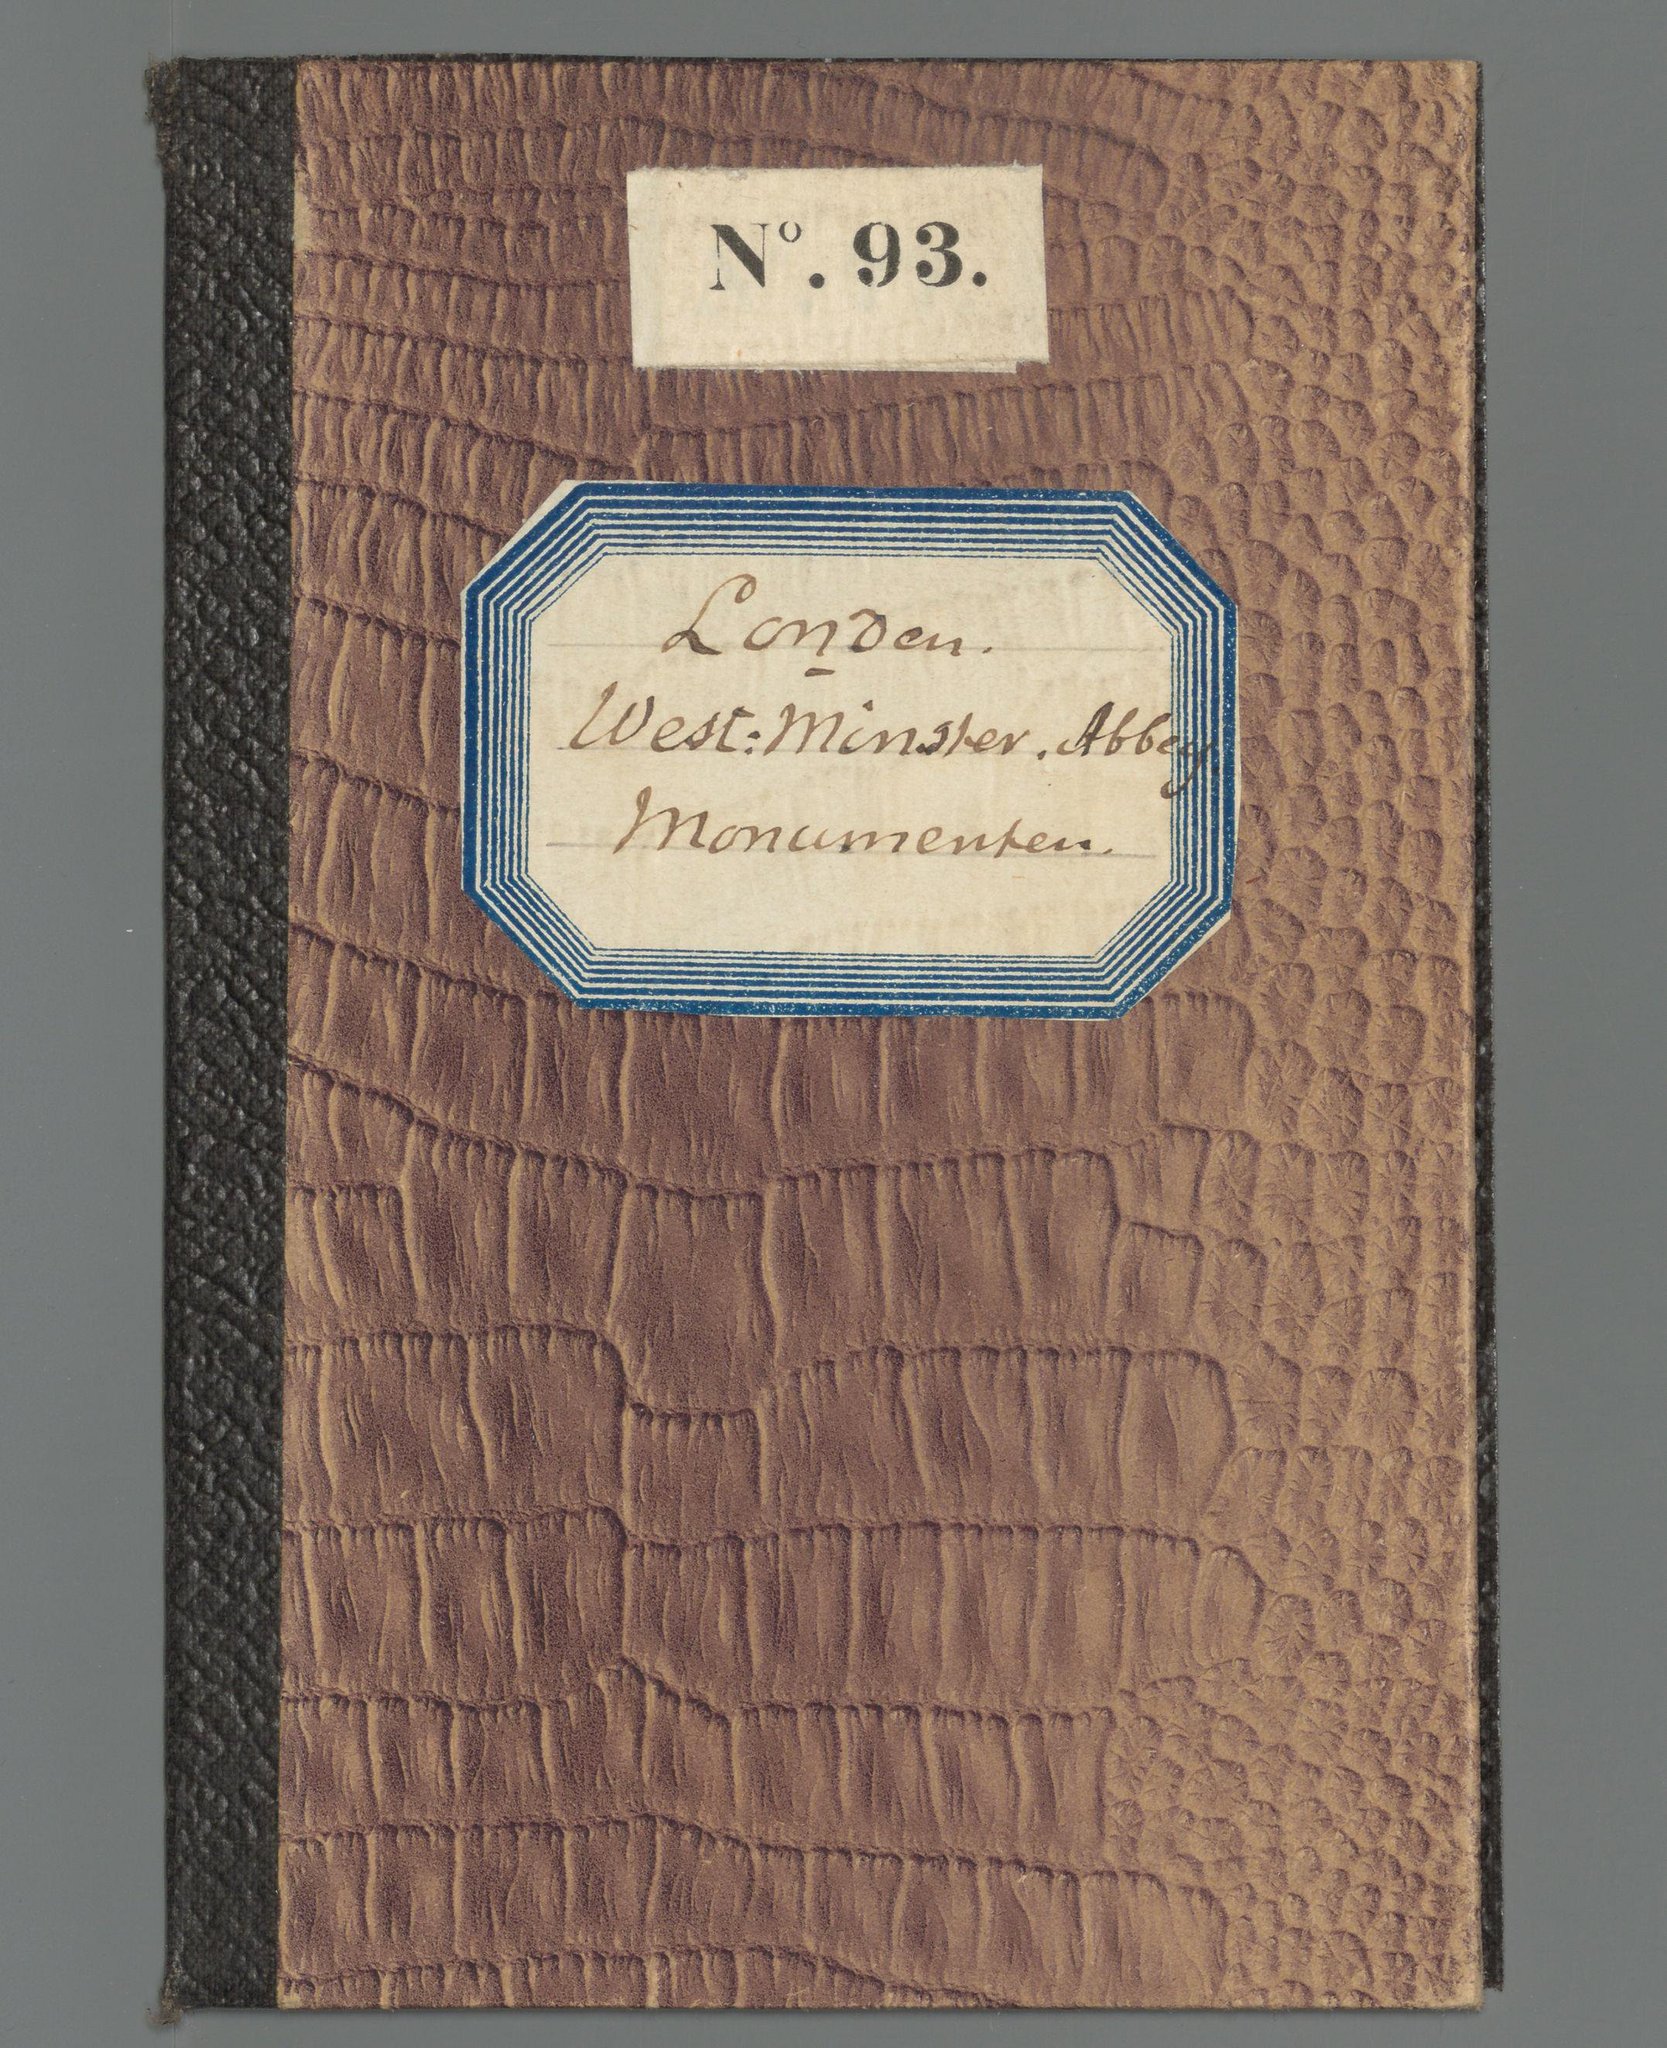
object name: wrapper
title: Omslag voor 37 prentbriefkaarten met stadsgezichten uit London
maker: Anonymous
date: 1900-1950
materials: cardboard, paper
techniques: lithograph, writing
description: In de omslag zit een kaart ingestoken met daarop een korte beschrijving van de inhoud.